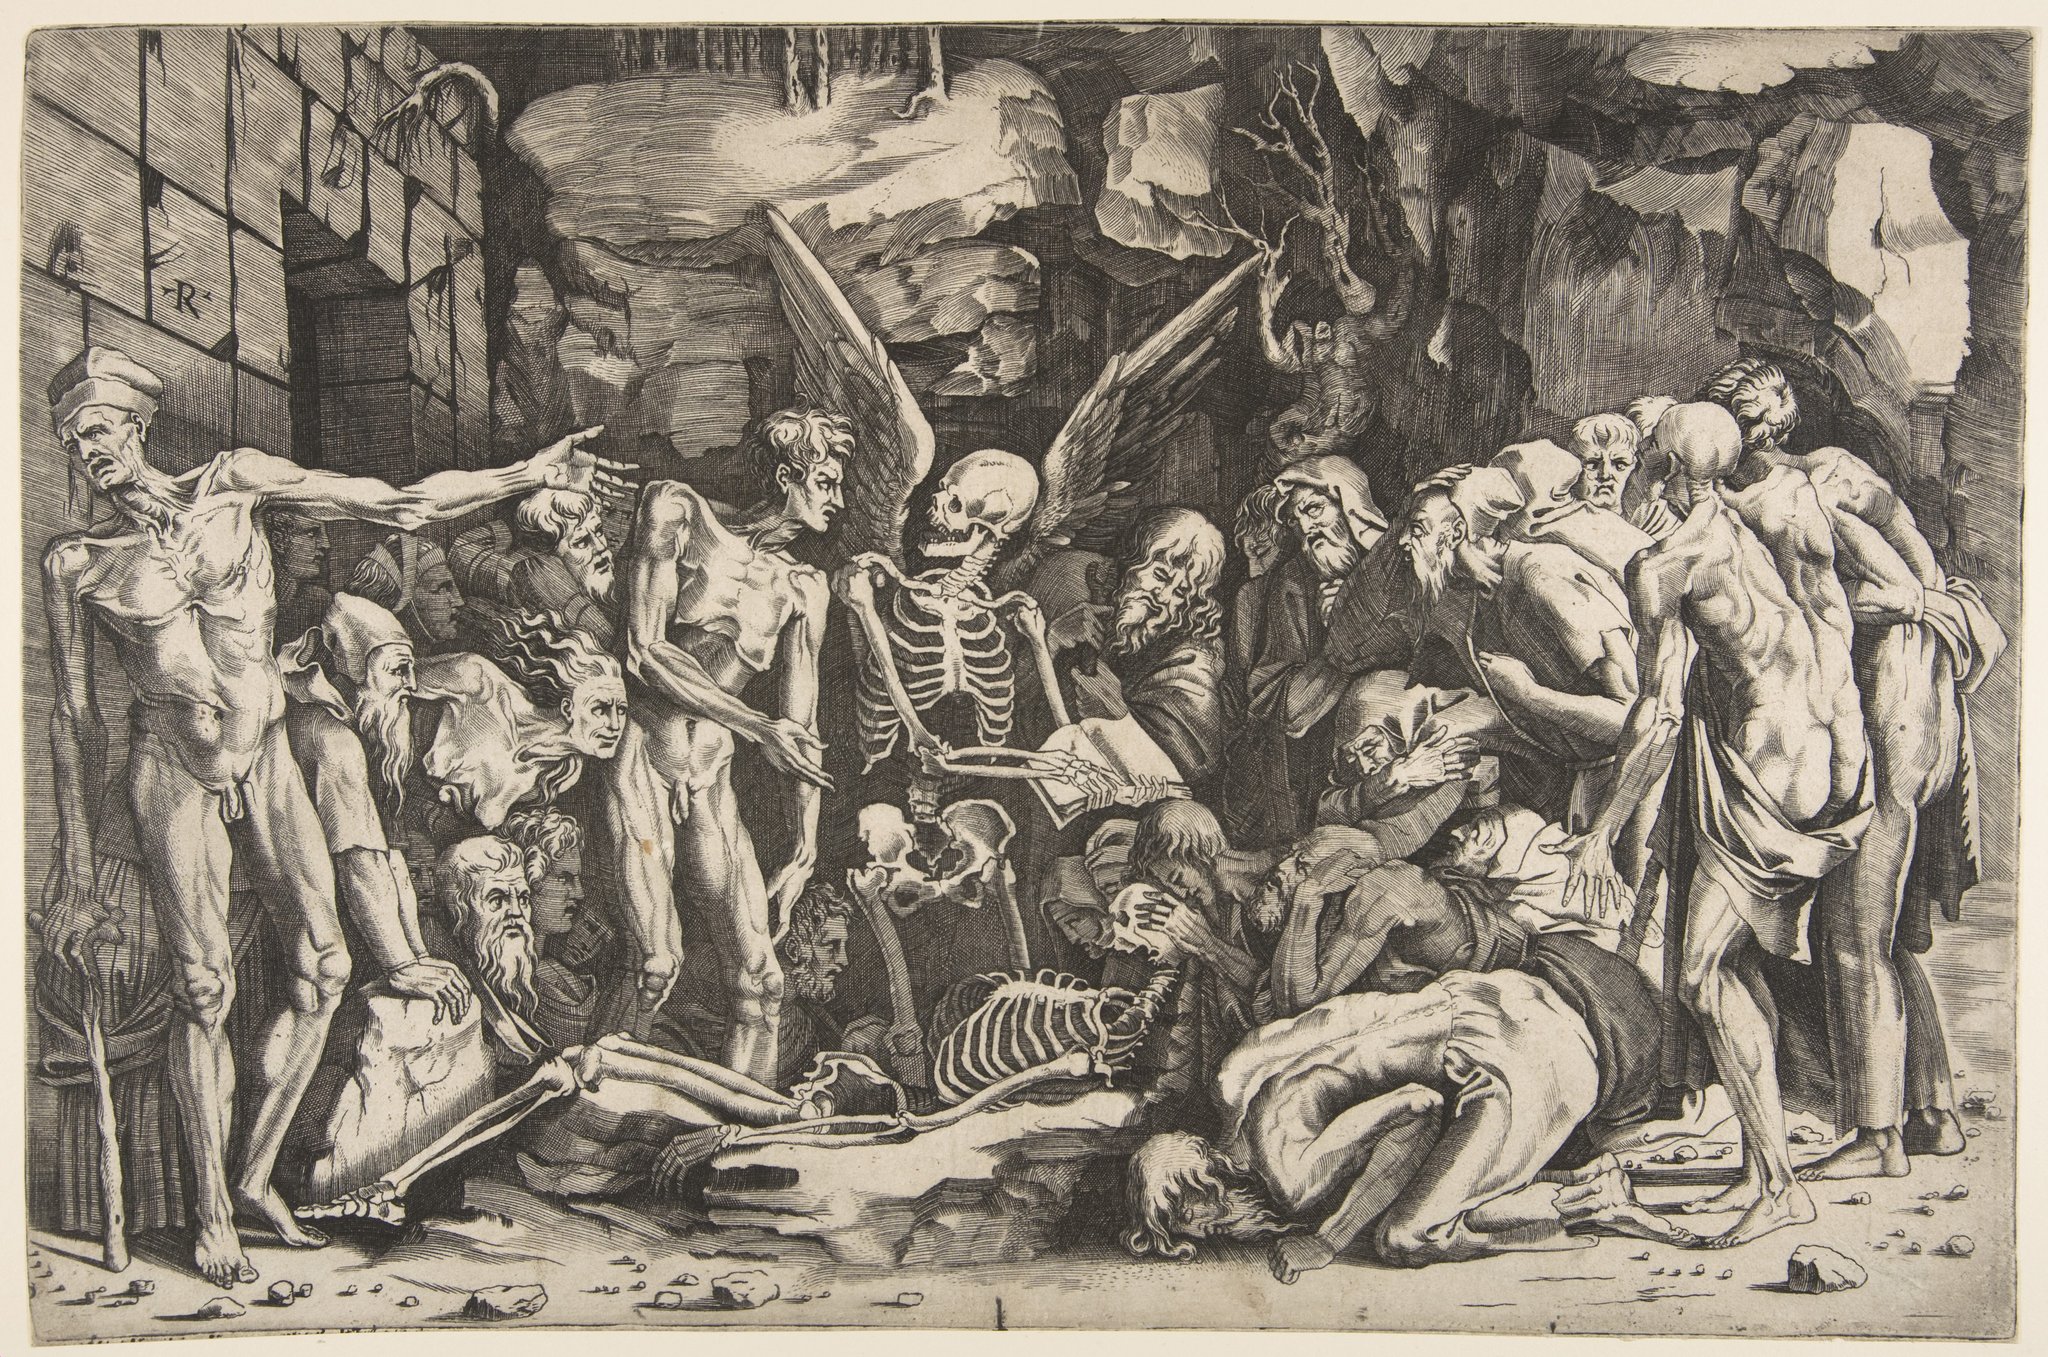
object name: print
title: The Skeletons, a group of emaciated men and women gathered around a skeleton laid on the ground and a figure of Death as a winged skeleton standing above it holding an open book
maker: marco dente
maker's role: artist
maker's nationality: italian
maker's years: 1515-1527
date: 1515-1527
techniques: engraving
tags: skeletons,men,women,death